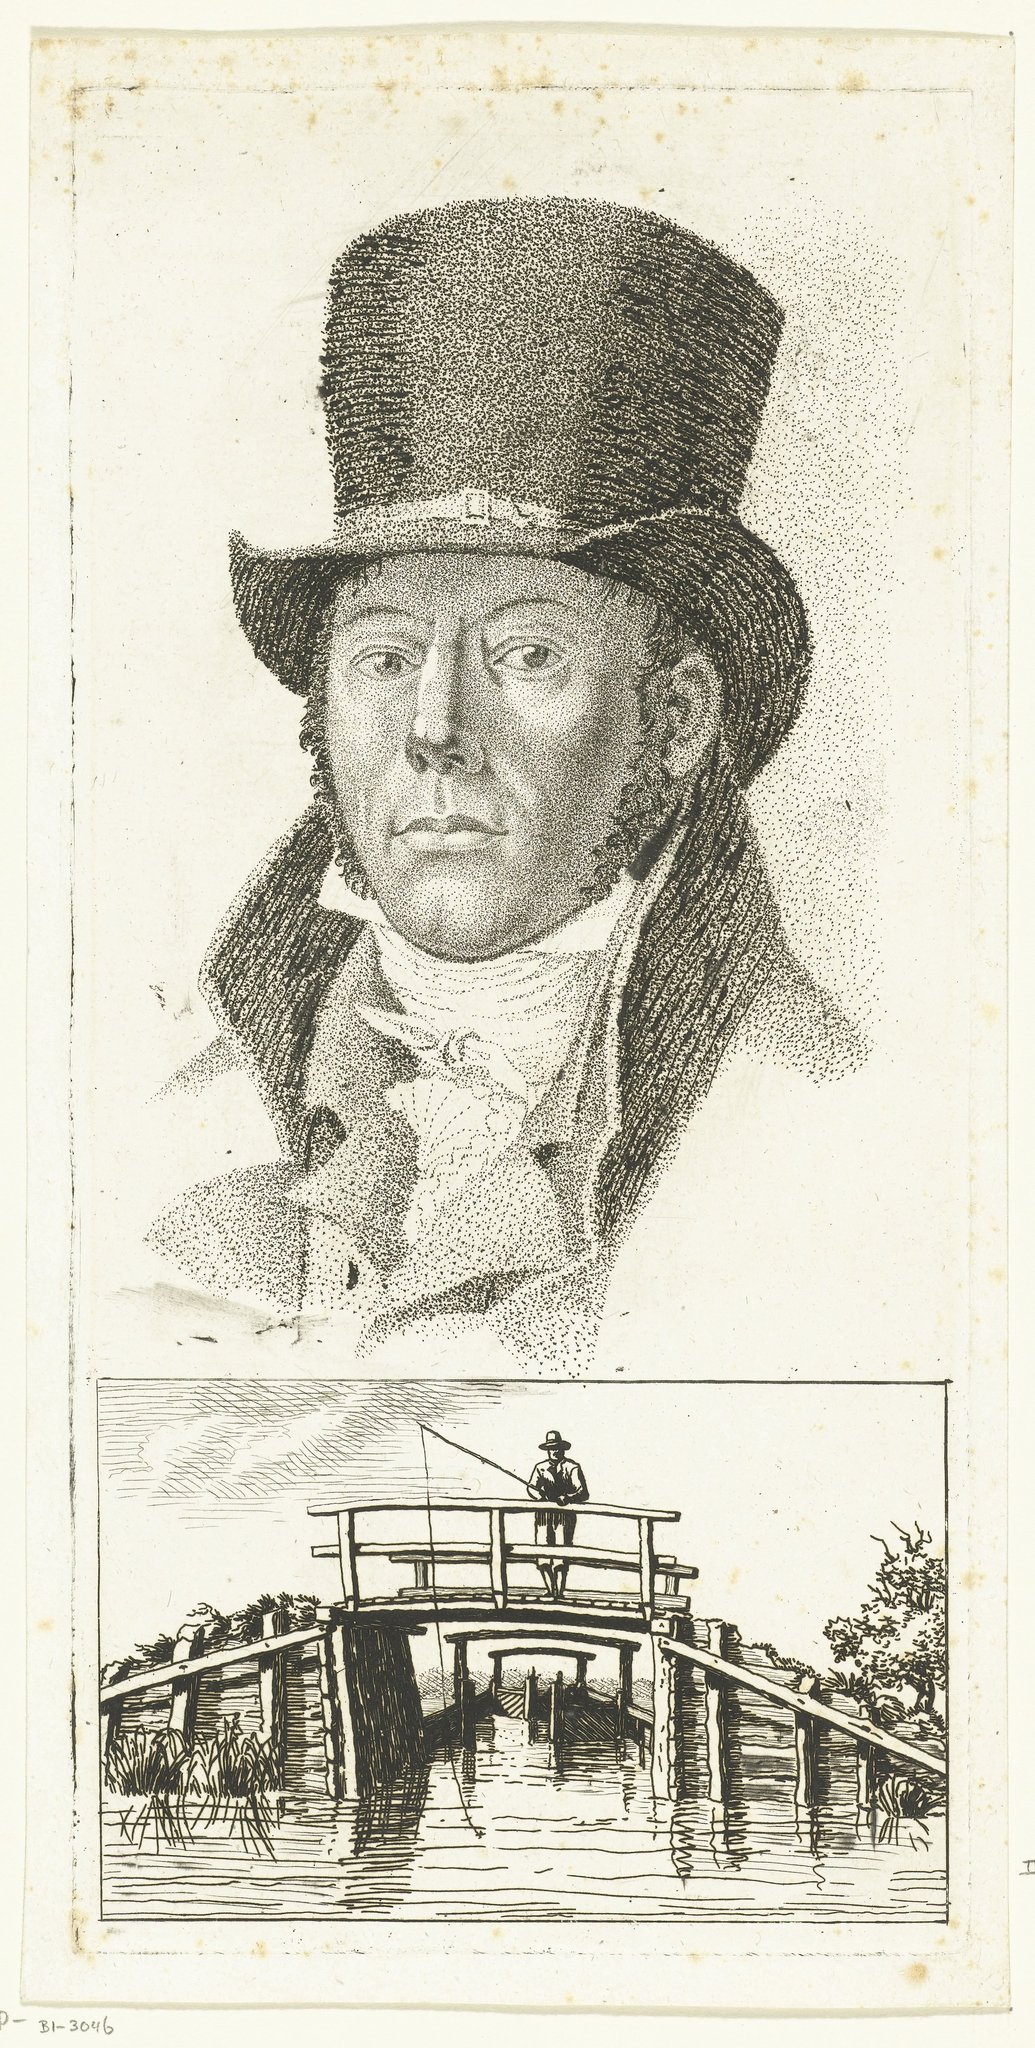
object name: print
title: Portret van Jacob Ernst Marcus met hoge hoed; hieronder een hengelaar op een brug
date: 1805-1838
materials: paper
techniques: aquatint, etching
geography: netherlands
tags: amsterdam, print maker, draughtsman, jacob ernst marcus, angling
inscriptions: collector's mark: Lugt 2228